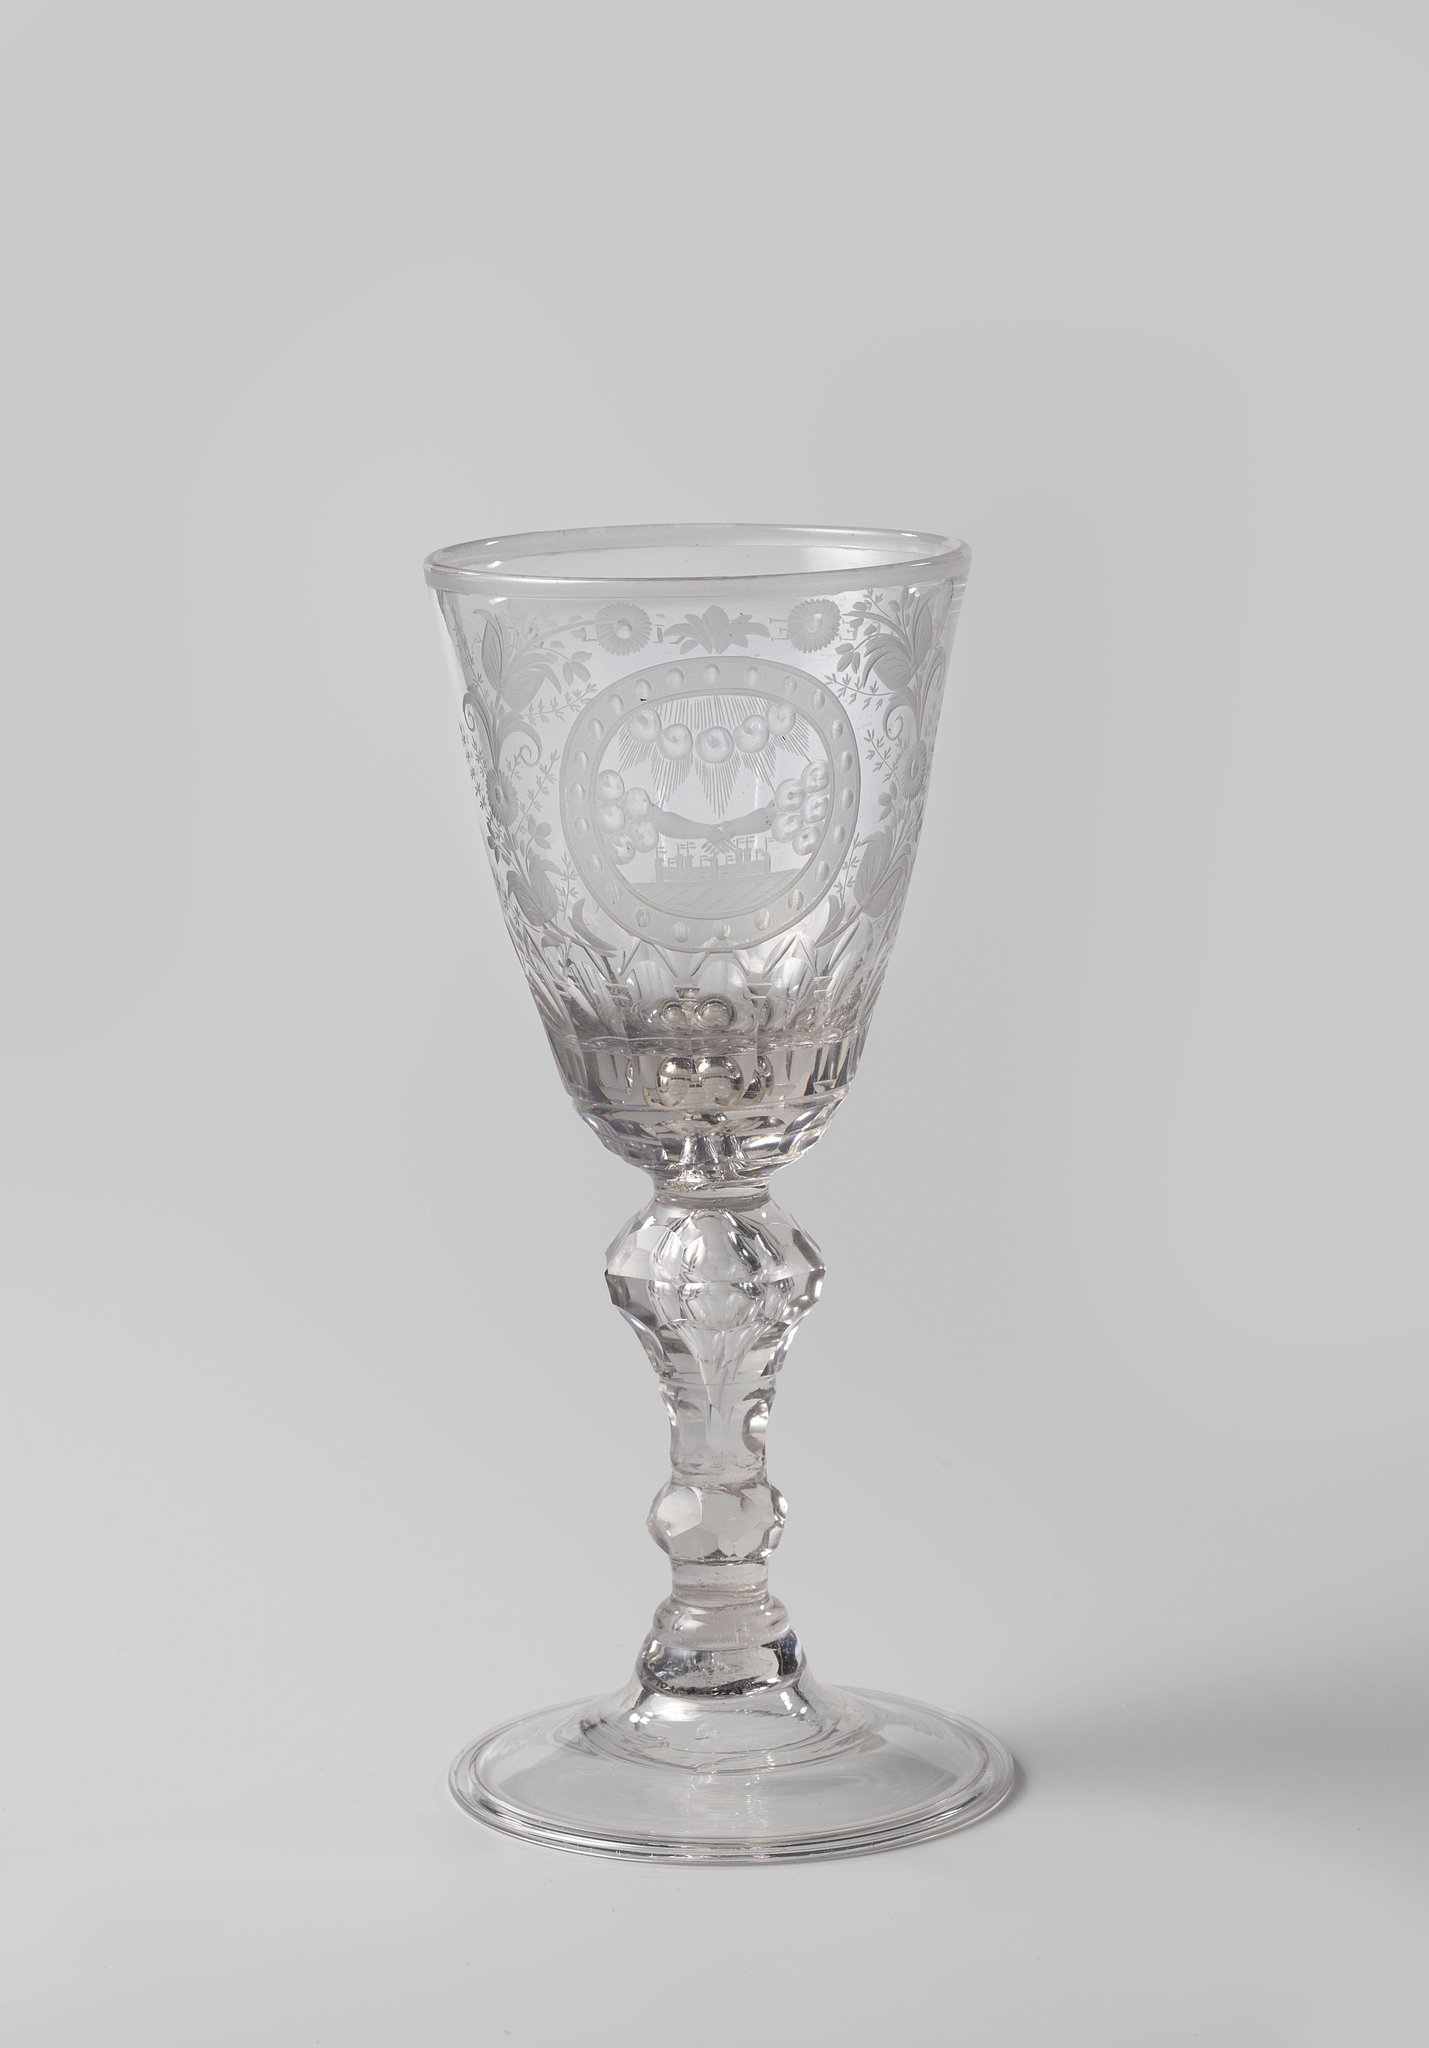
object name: goblet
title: Bokaal met twee ineengeslagen handen en het opschrift: DE GOEDE VRIND SCHAP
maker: Anonymous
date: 1725-1750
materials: glass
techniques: glassblowing, grinding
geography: germany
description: Bokaal, geslepen balusterstam. De geslepen kelk vertoont in een cirkelrand twee handen. Om dit medaillon een bloemkrans en de woorden: DE GOEDE VRIND SCHAP.